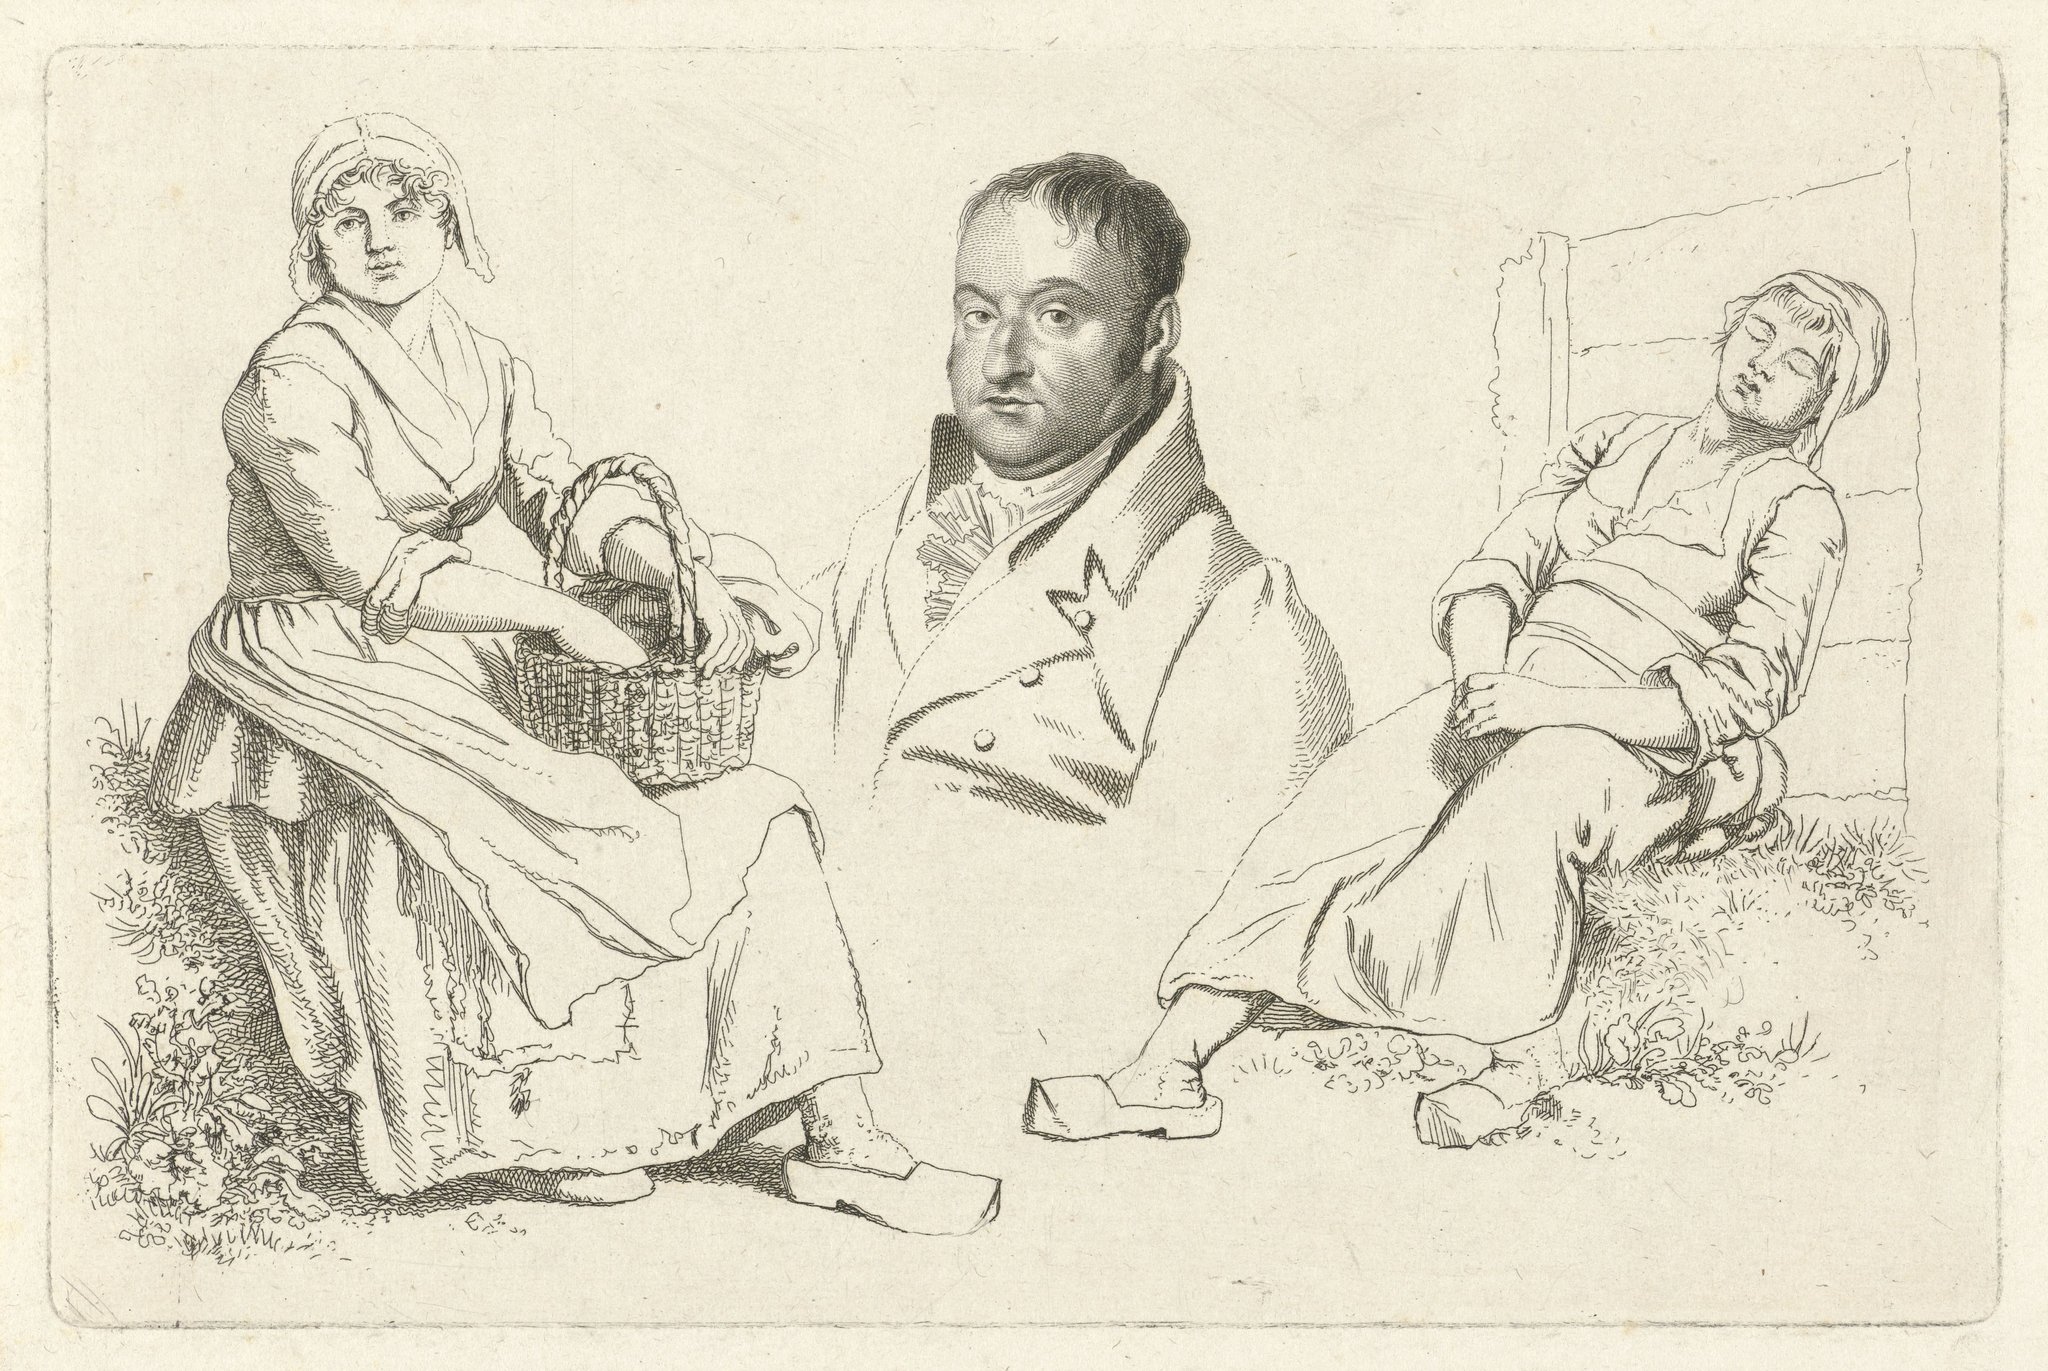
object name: print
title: Portret van Daniel Vrijdag tussen twee boerinnen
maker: jacob ernst marcus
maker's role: draughtsman, print maker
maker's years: 1774-1826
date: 1812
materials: paper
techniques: etching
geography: amsterdam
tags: the hague, amsterdam, print maker, draughtsman, daniël vrijdag, sitting figure - aa - female human figure, sleeping; unconsciousness - bb - out of doors, wooden shoes, clogs, farmers - aa - female farmer, farmer's wife, container made of plant material other than wood: basket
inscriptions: collector's mark: Lugt 2228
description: Latere staat van de prent gebruikt in: Jacob Ernst Marcus, Etudes gravées. Amsterdam: S. de Grebber, 1826.